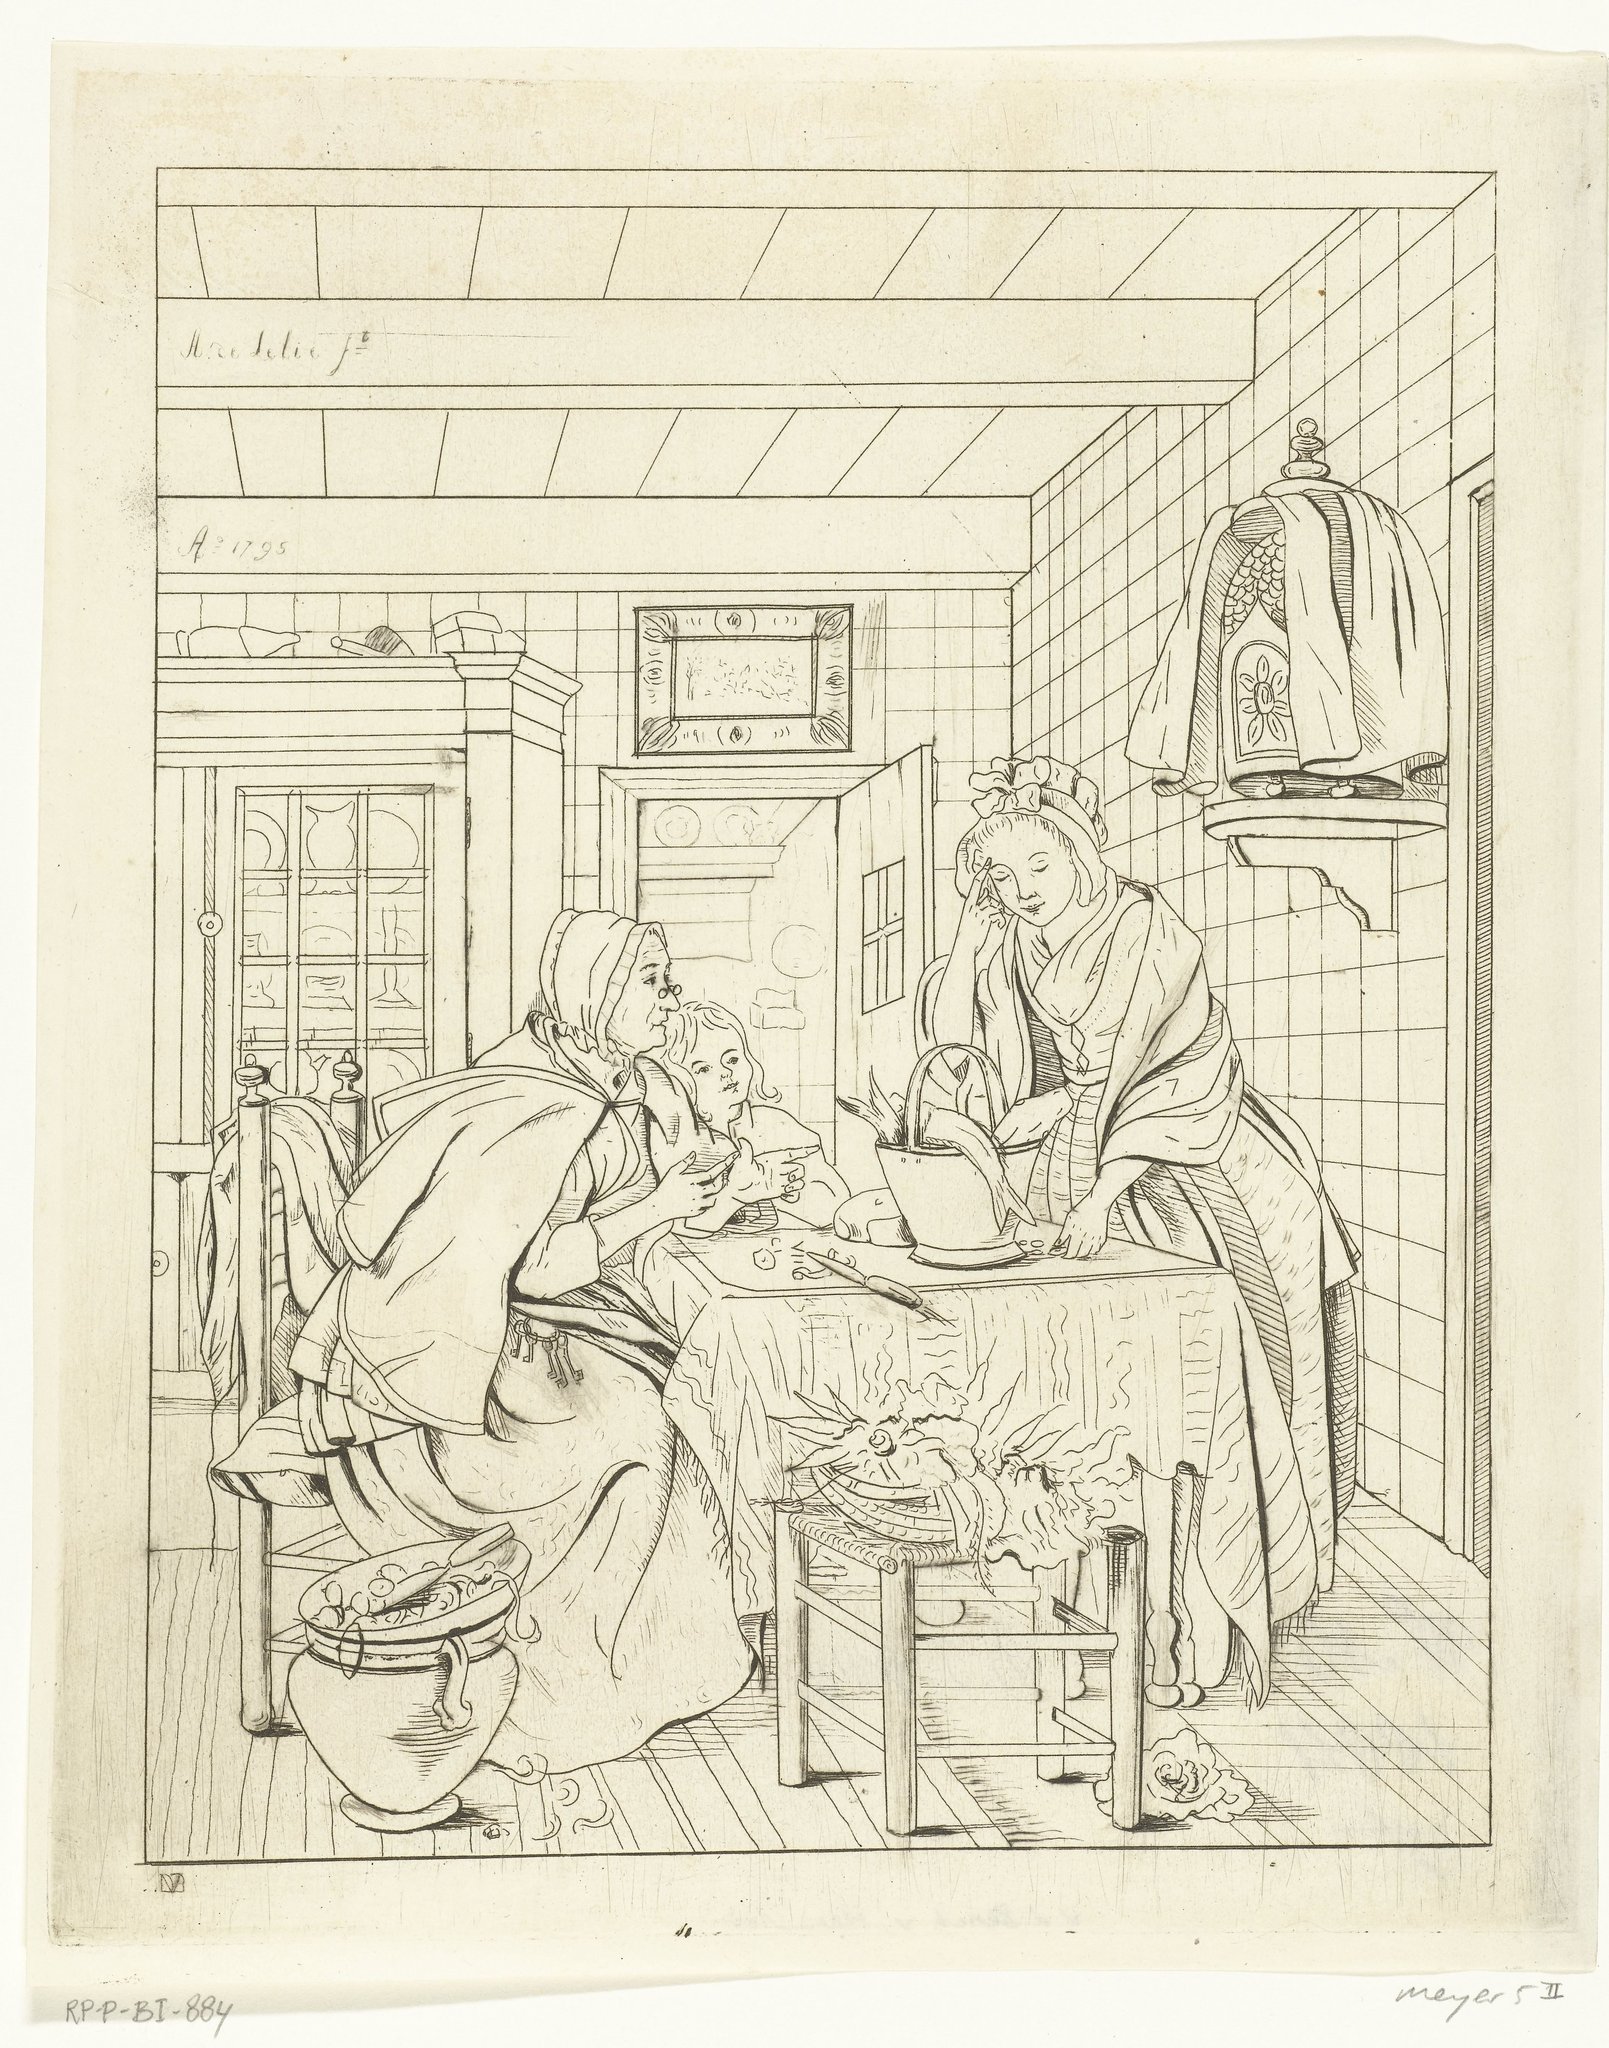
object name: print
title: Maid giving Groceries to an Old Woman in a Kitchen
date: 1829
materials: paper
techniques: etching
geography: netherlands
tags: kitchen, house personnel, servants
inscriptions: collector's mark: Lugt 2228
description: Dienstmeid heeft verse vis gehaald en telt het geld dat ze nog heeft voor oude vrouw aan tafel in keuken.